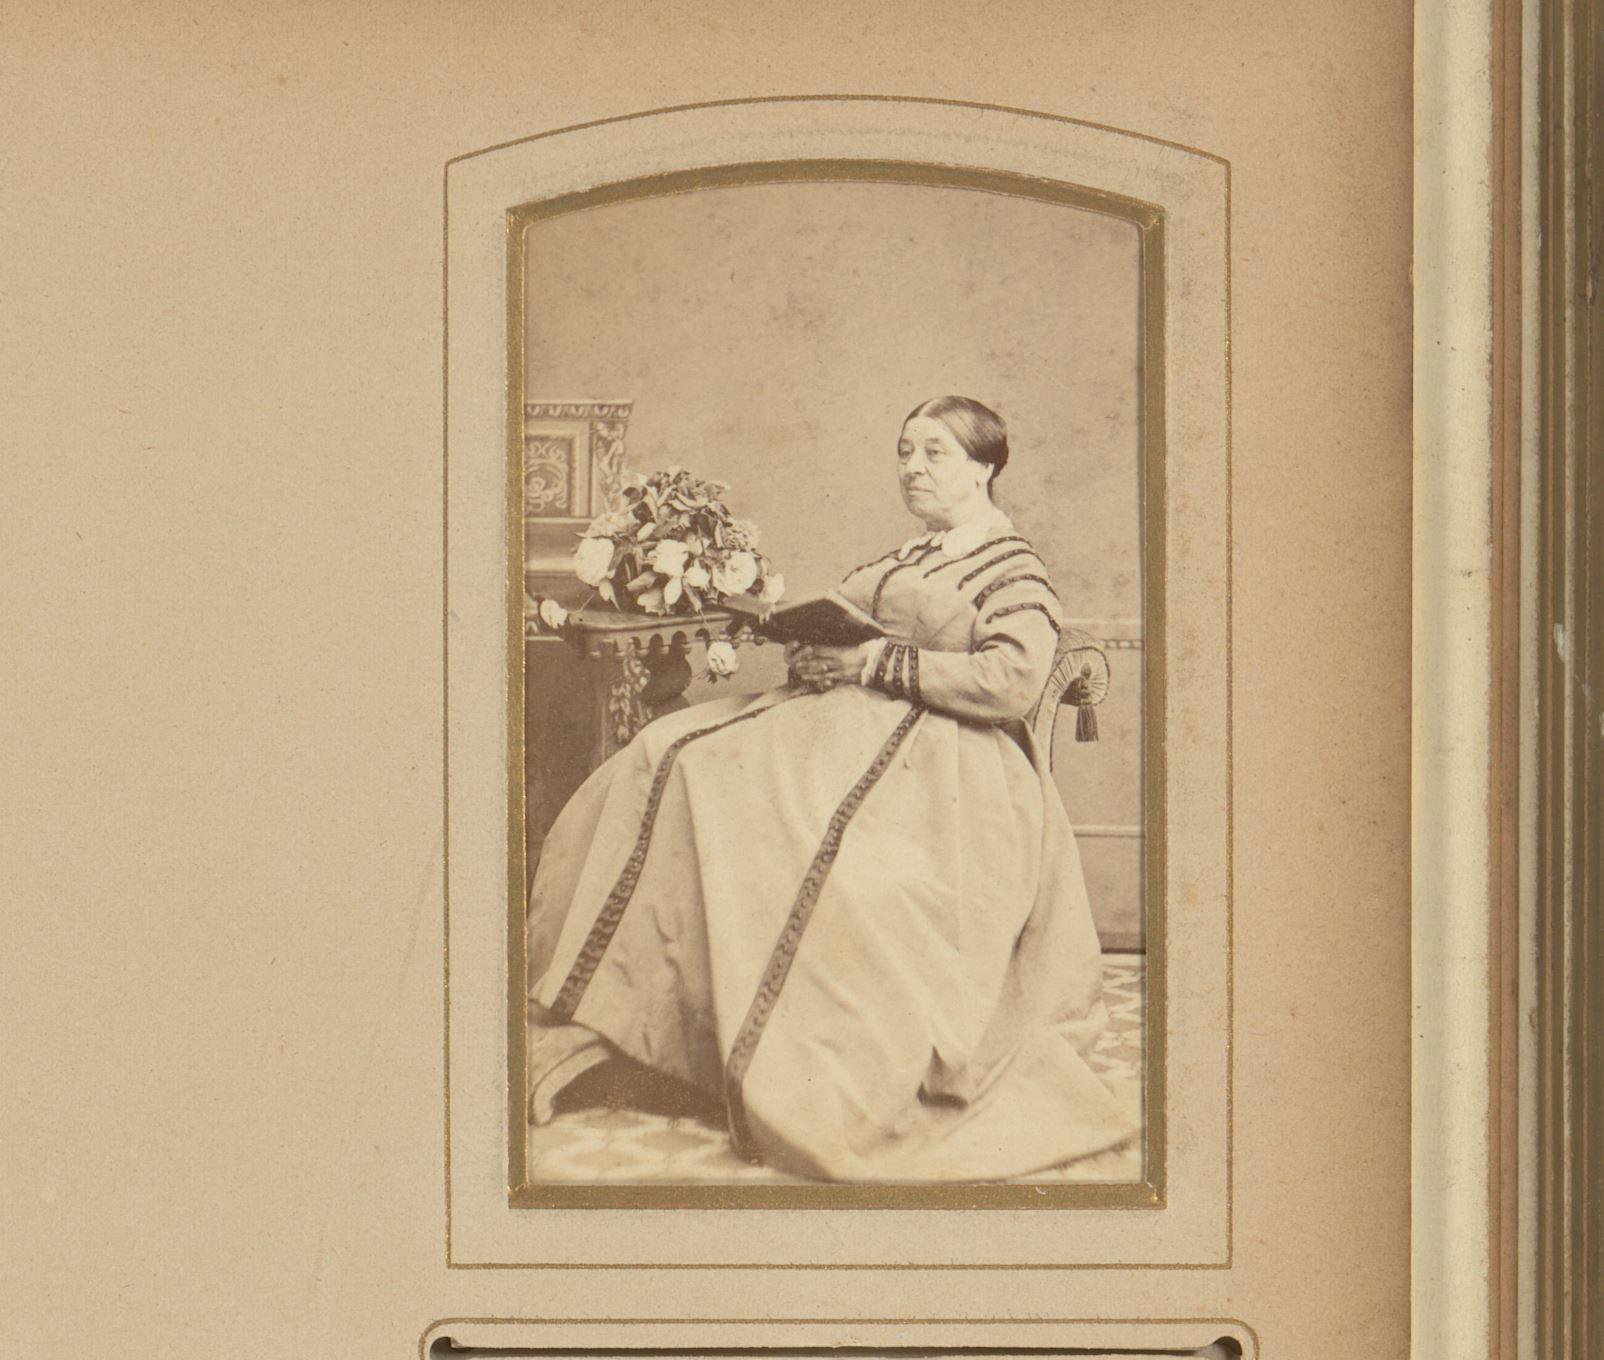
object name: album leaf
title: Portret van een zittende vrouw met open boek in de hand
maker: antoni verryck-fleetwood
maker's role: fotograaf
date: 1880-1890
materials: cardboard, photographic support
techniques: albumen print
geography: antwerp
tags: historical persons - bb - woman, book - mm - book open, standing figure - aa - female human figure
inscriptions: inscription: ‘PHOTOGRAPHIE ANGLAISE/ ANTONI VERRYCK-FLEETWOOD/ TIRLEMONT/ Les Clichés se conservant indéfiniment/ on peut toujours se procurer de nouvelles/ épreuves de ce Portrait sans reposer.’